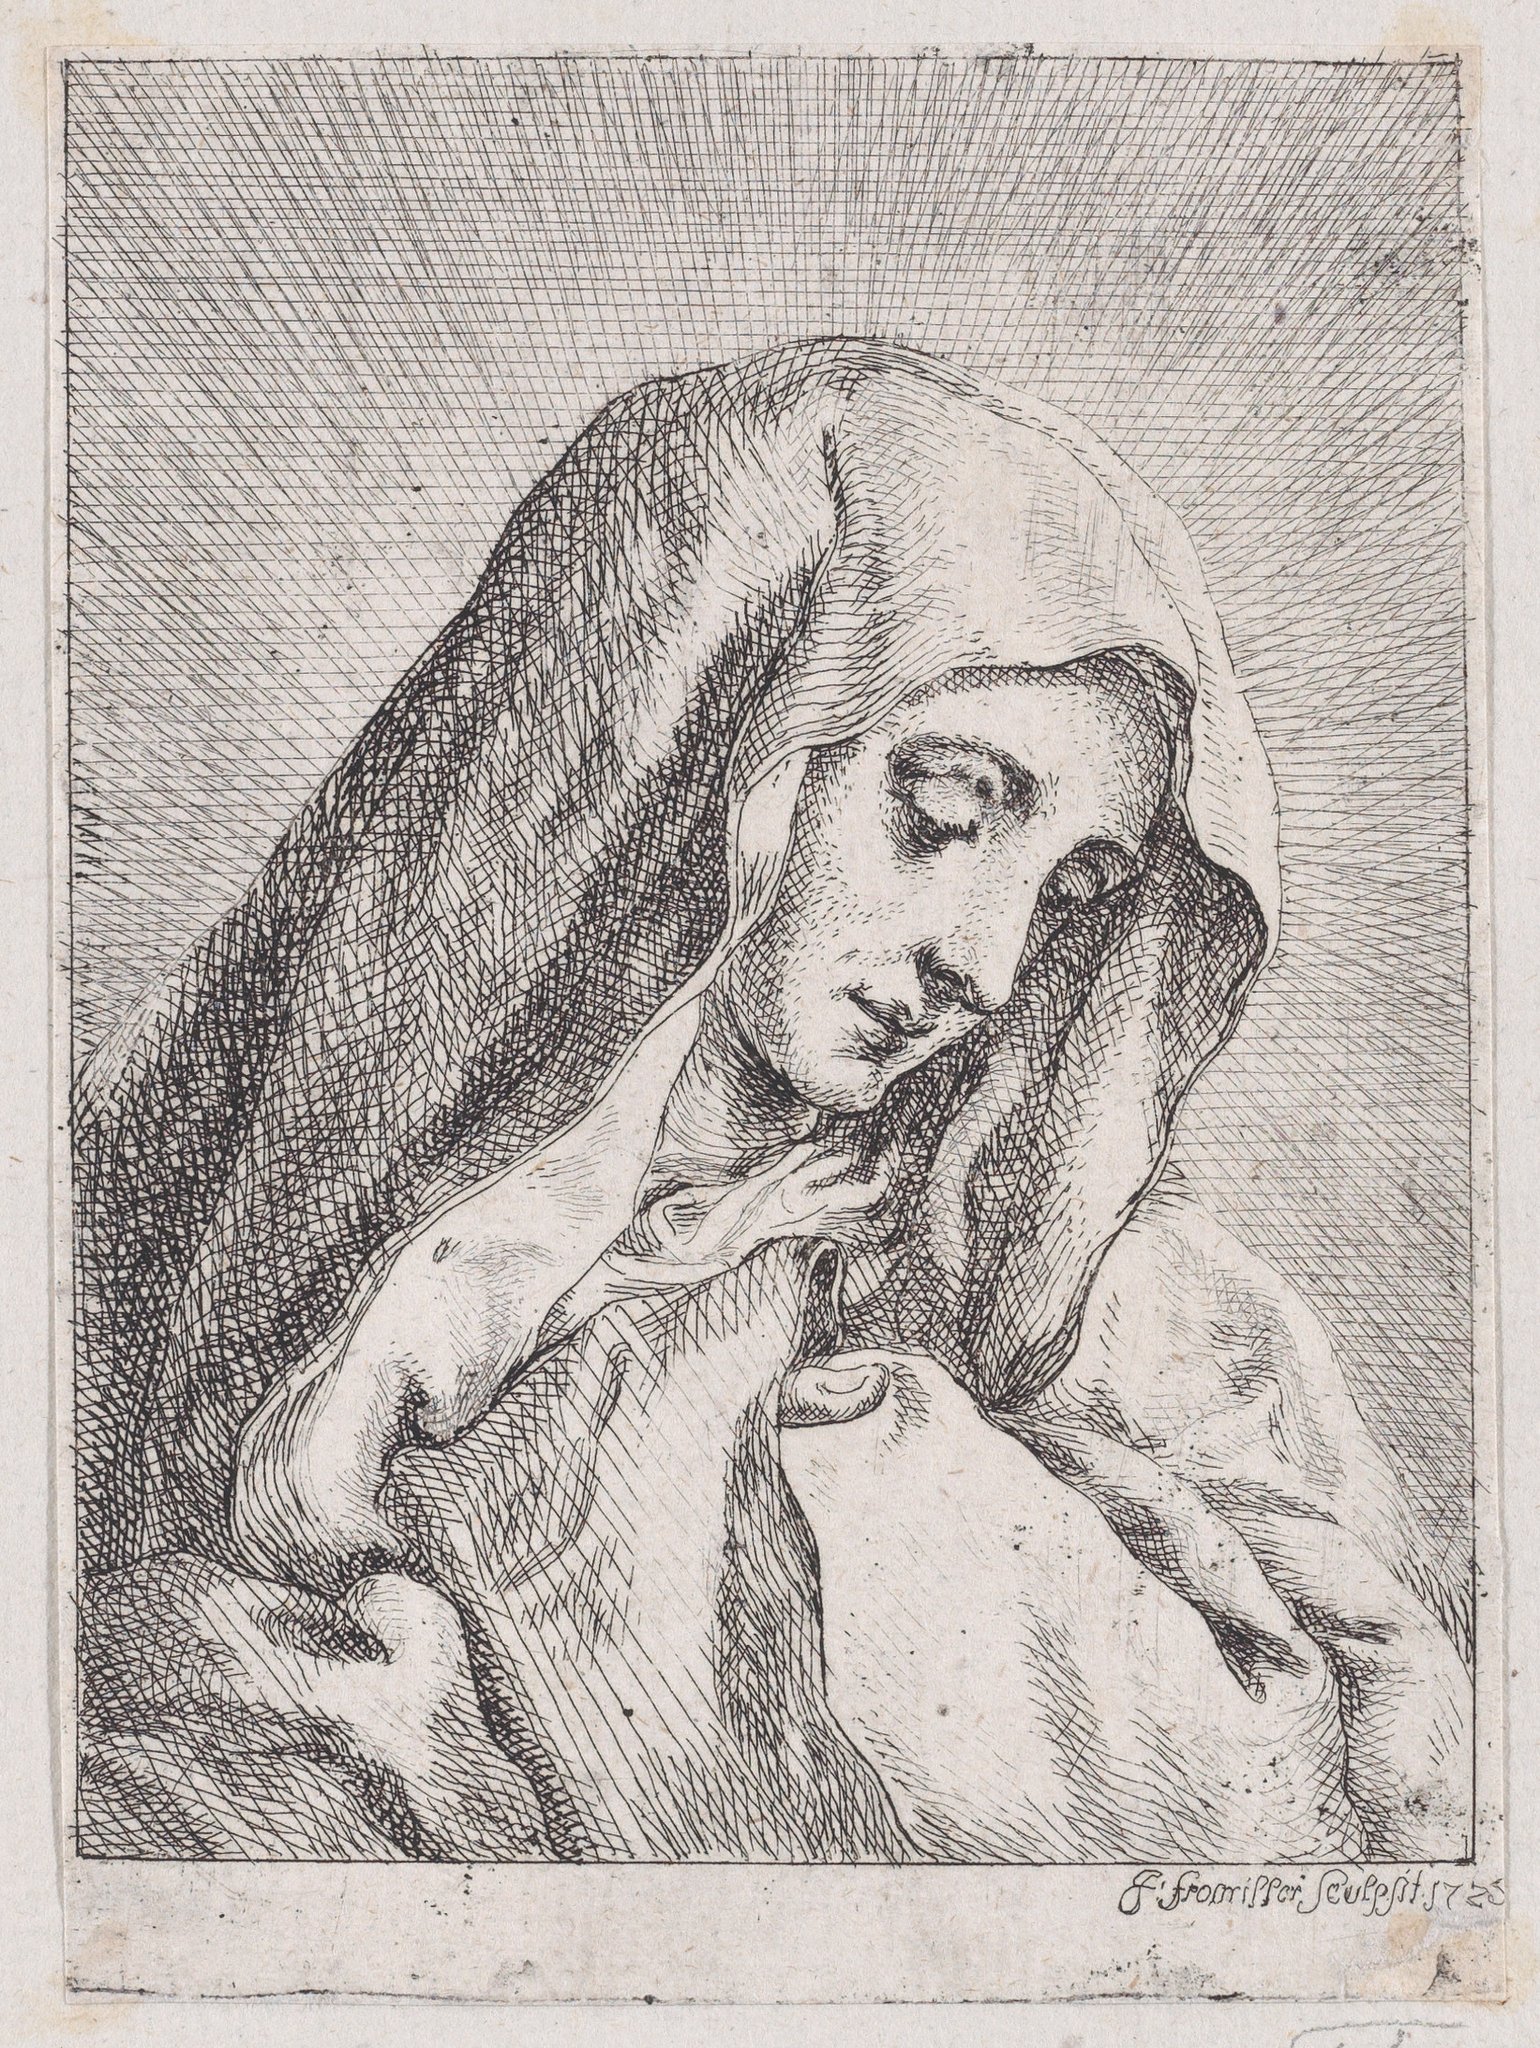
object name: print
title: Head of the Madonna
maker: josef ferdinand fromiller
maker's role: artist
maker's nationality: german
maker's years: 1693-1760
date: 1725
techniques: etching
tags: virgin mary